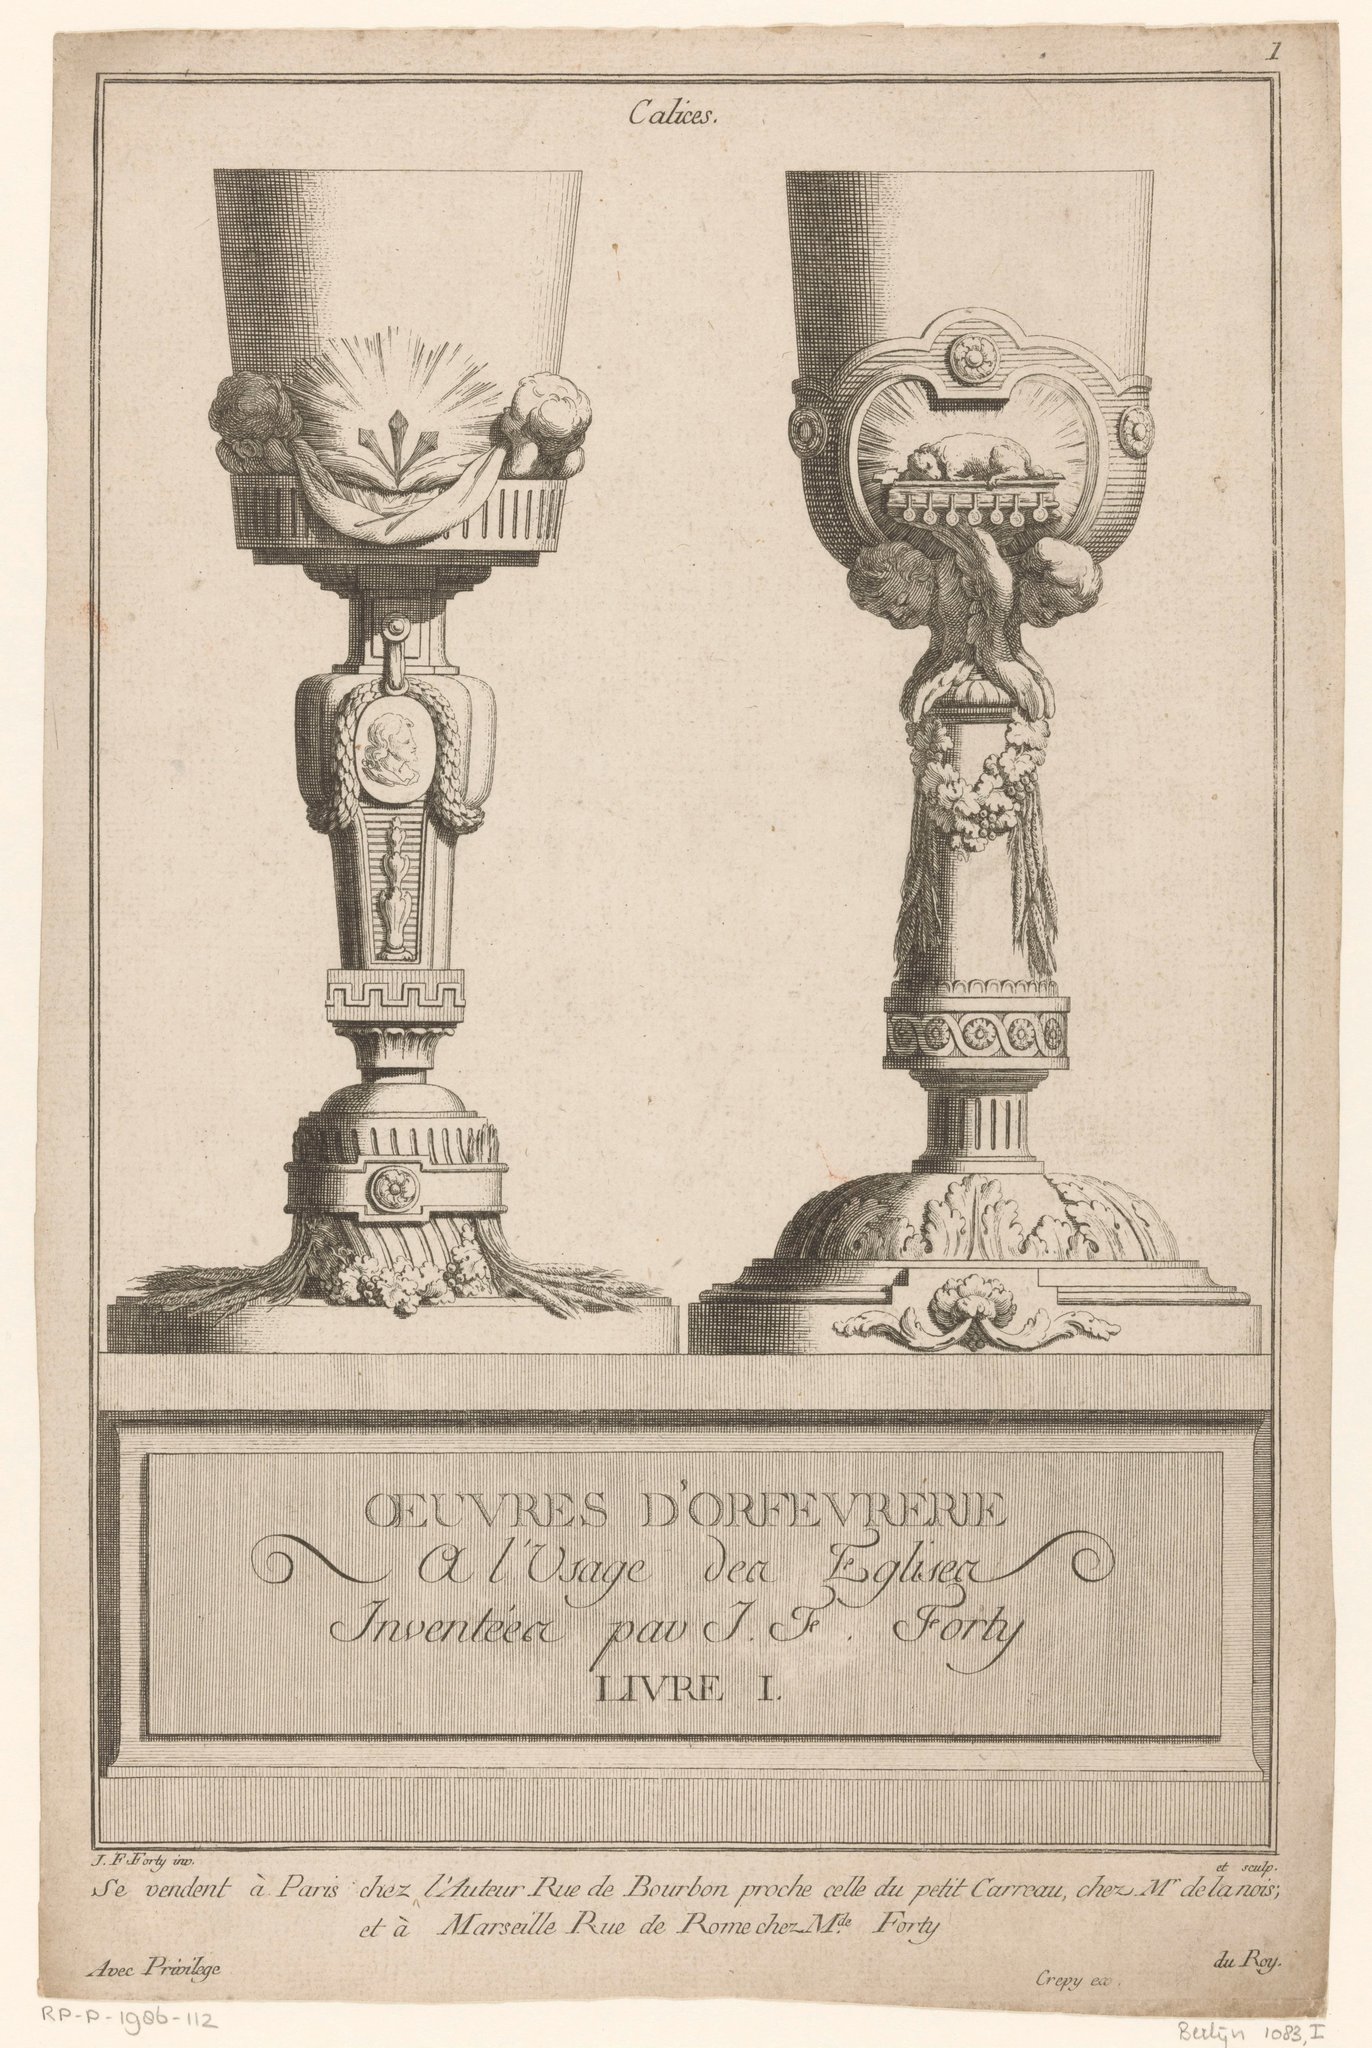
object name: titelprent, frontispice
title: Oeuvres D'Orfevrerie A l'Usage des Eglises (...) Livre I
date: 1775-1790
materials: paper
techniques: engraving, etching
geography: paris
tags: chalice, cupids: 'amores', 'amoretti', 'putti'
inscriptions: collector's mark: Lugt 2228, collector's mark: Lugt 2760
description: Twee geornamenteerde kelken met puttihoofden, rechts met lam op het boek van de zeven zegels. Daaronder de serietitel.